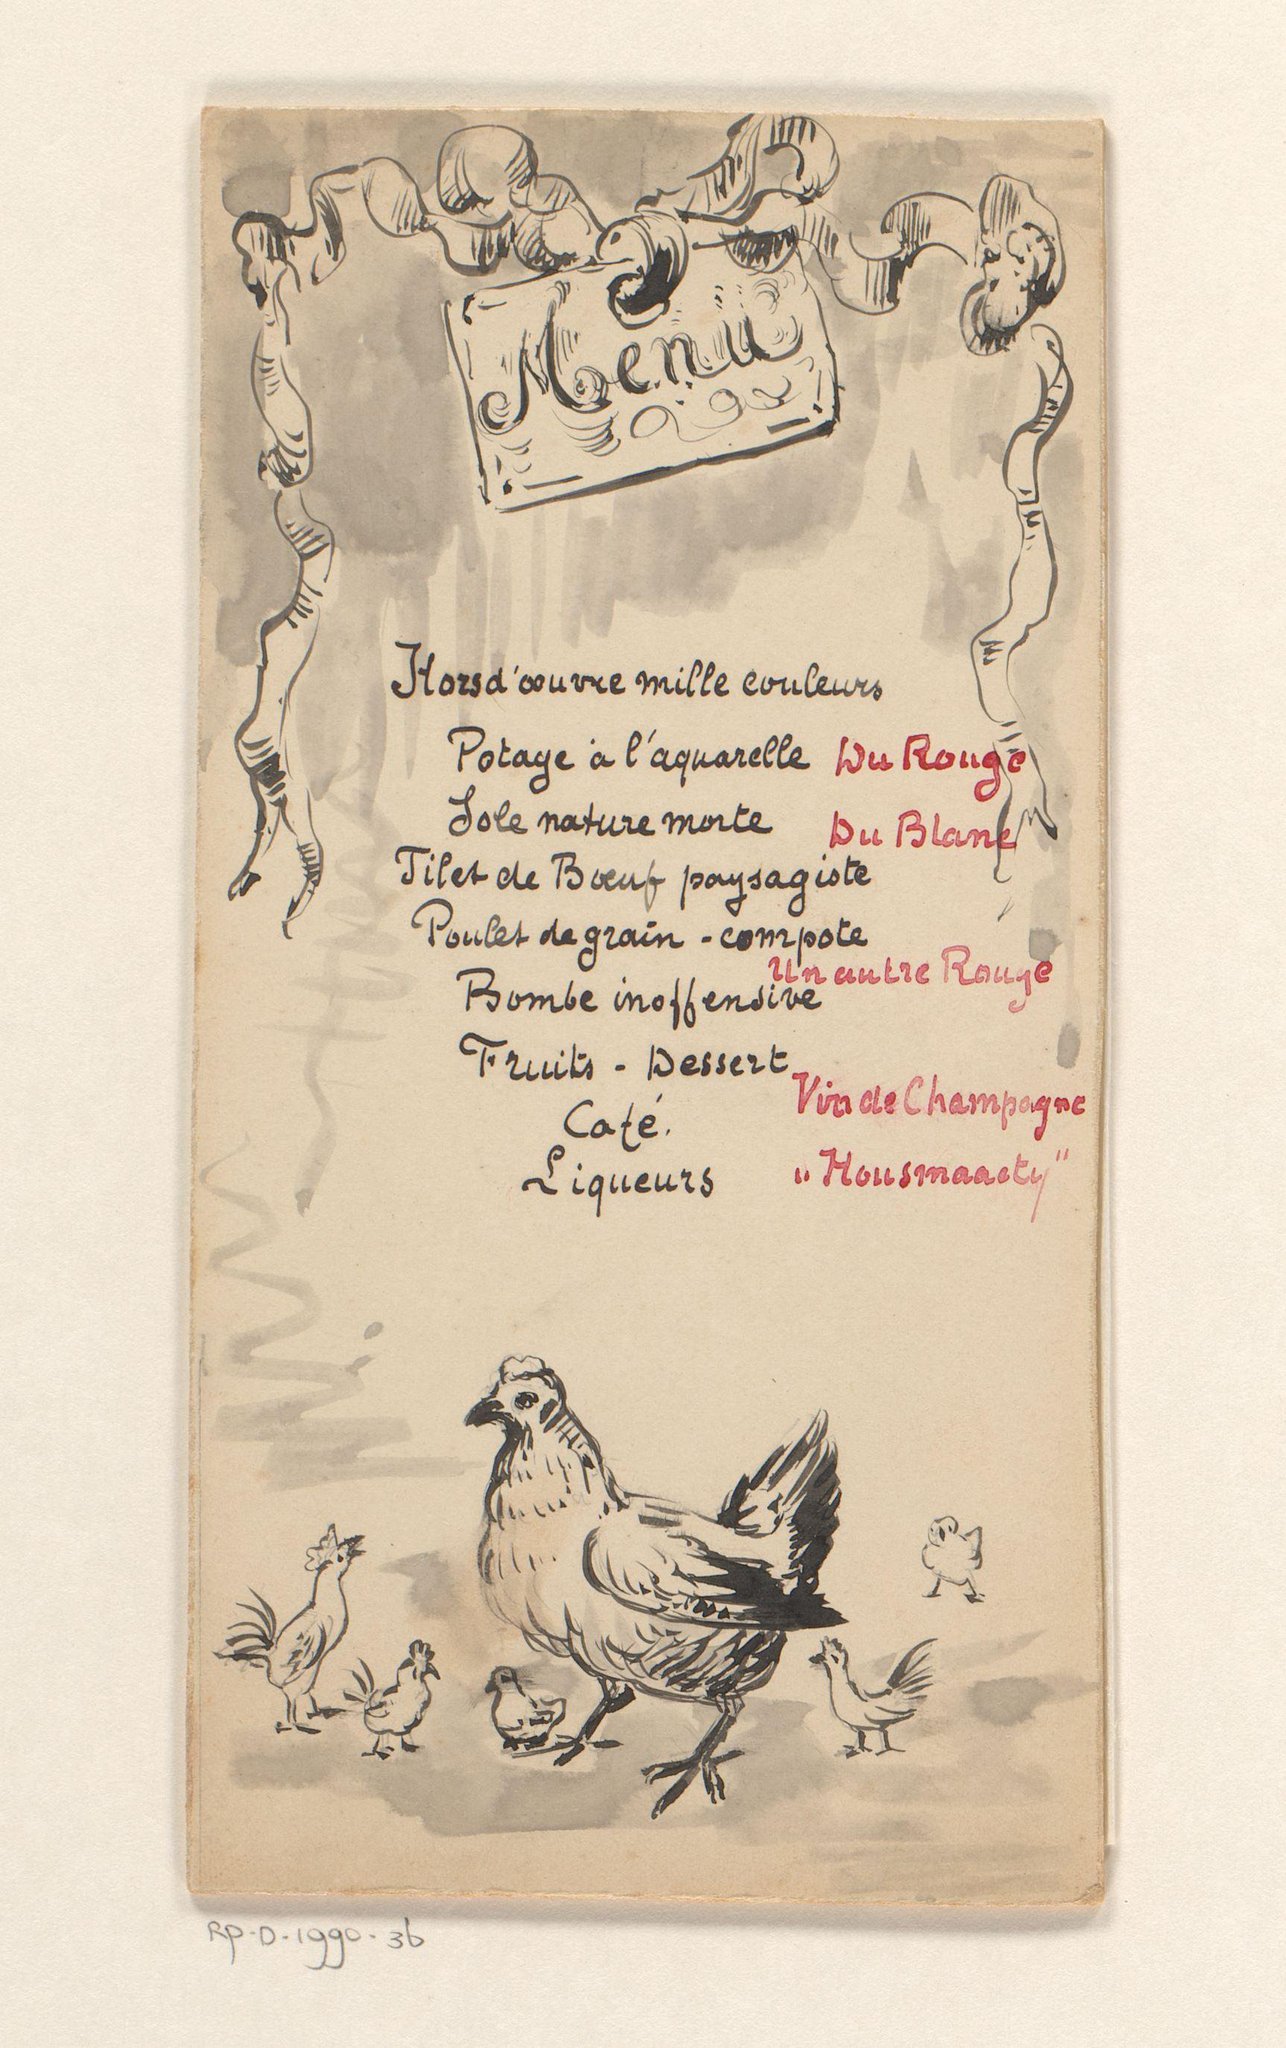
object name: drawing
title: Menukaart voor een diner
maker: Anonymous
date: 1880-1920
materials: ink, paper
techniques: brush, pen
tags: 43b311(+12)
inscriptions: collector's mark: Lugt 2228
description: Met een kip en enkele kuikens, en bovenaan een slinger met daaraan het woord 'Menu'. Op de achterzijde handtekeningen, waarschijnlijk van de aanwezigen.